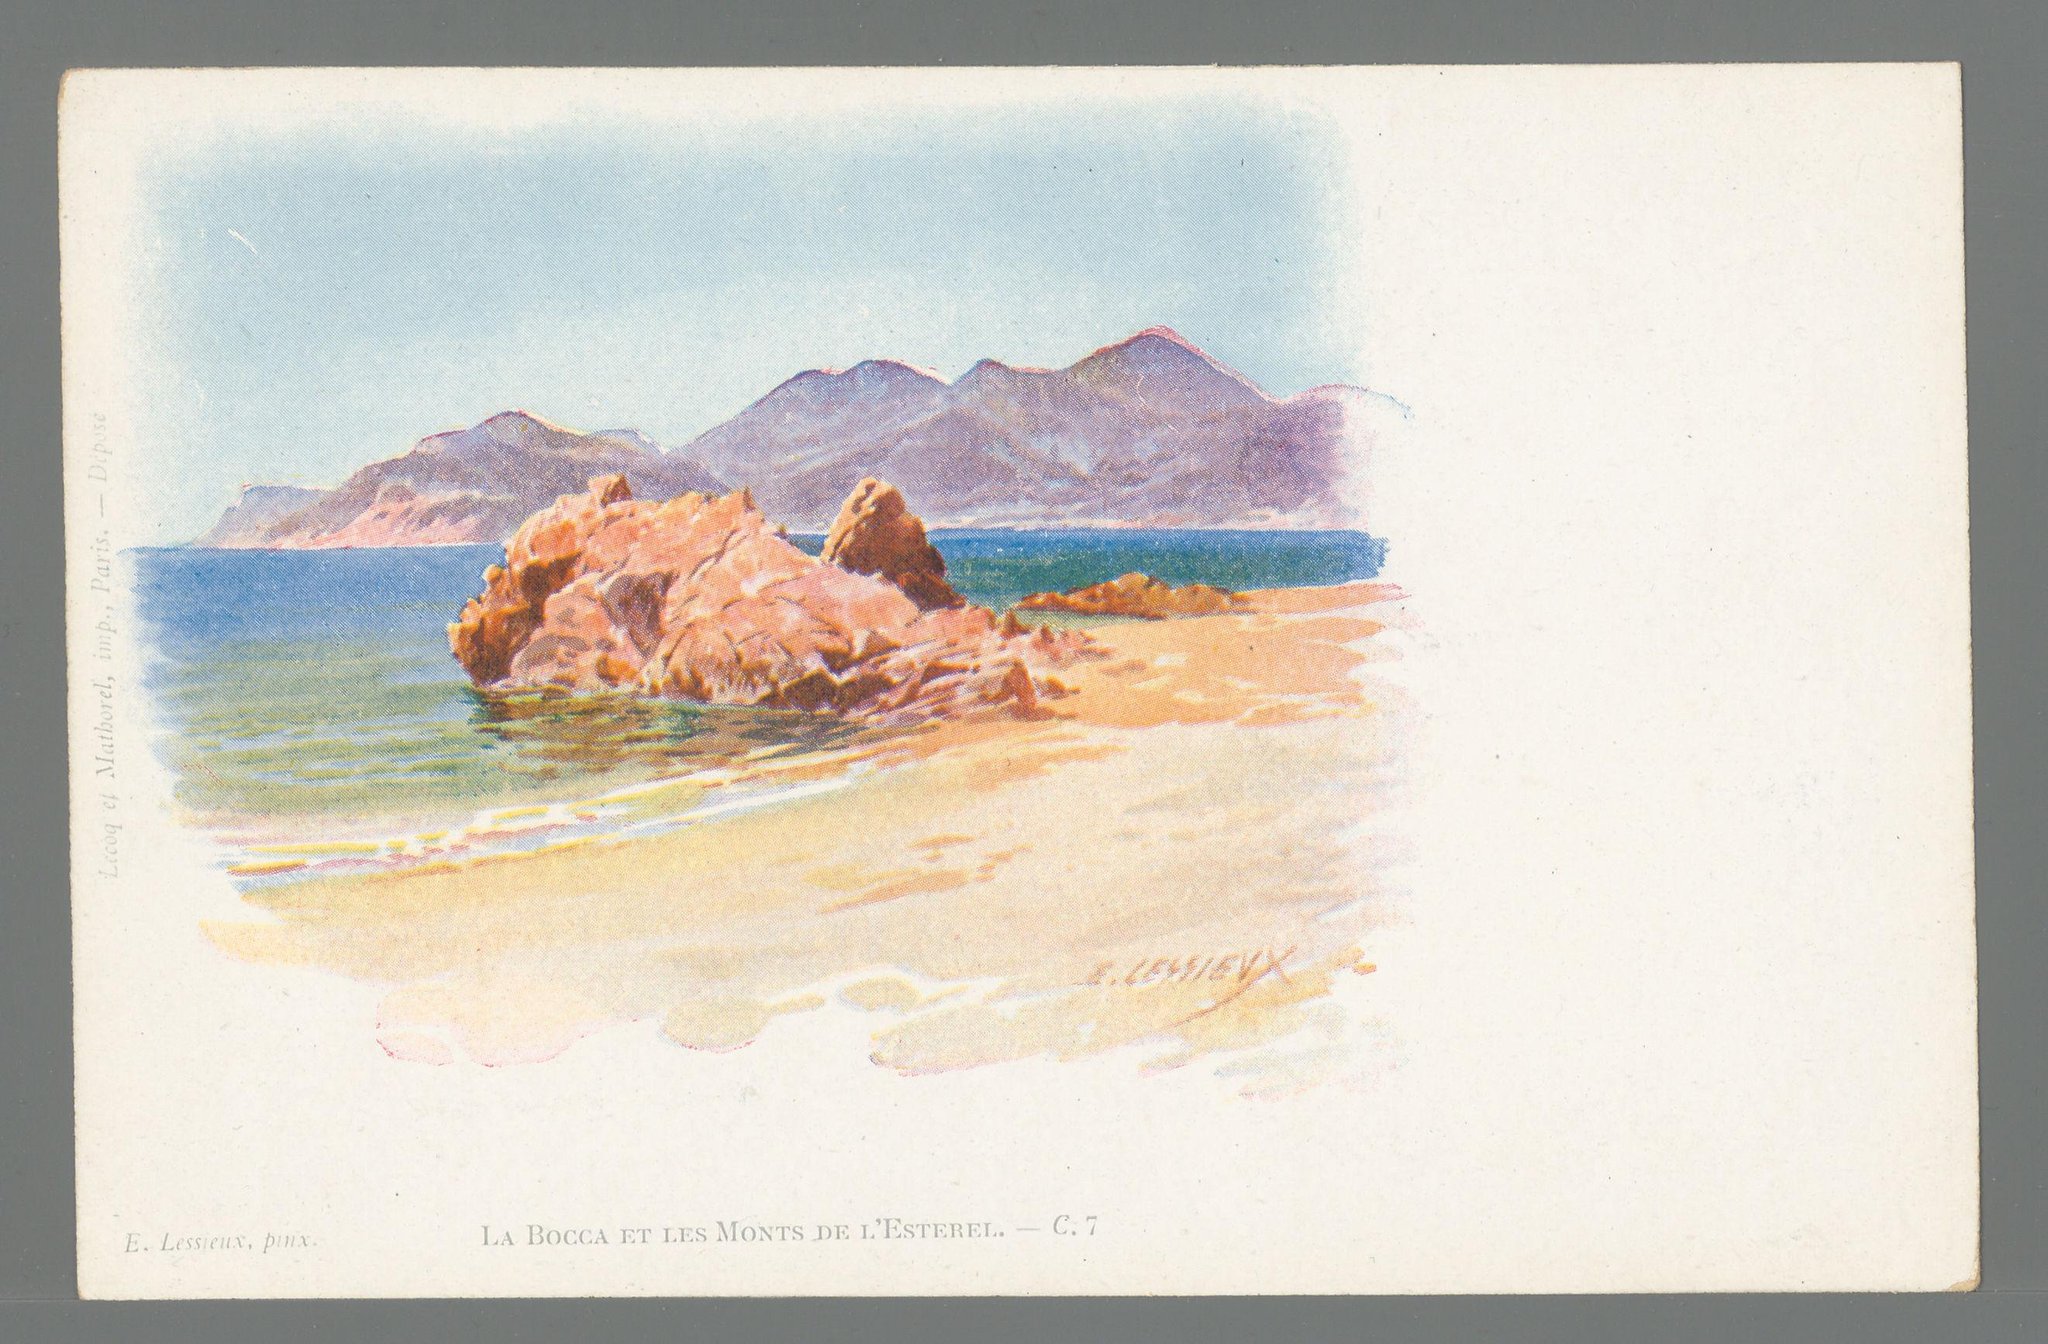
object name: photomechanical print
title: La Bocca et les Monts de l'Esterel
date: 1892-1904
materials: cardboard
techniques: writing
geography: paris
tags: landscapes with waters, waterscapes, seascapes (in the temperate zone), beach, mountains